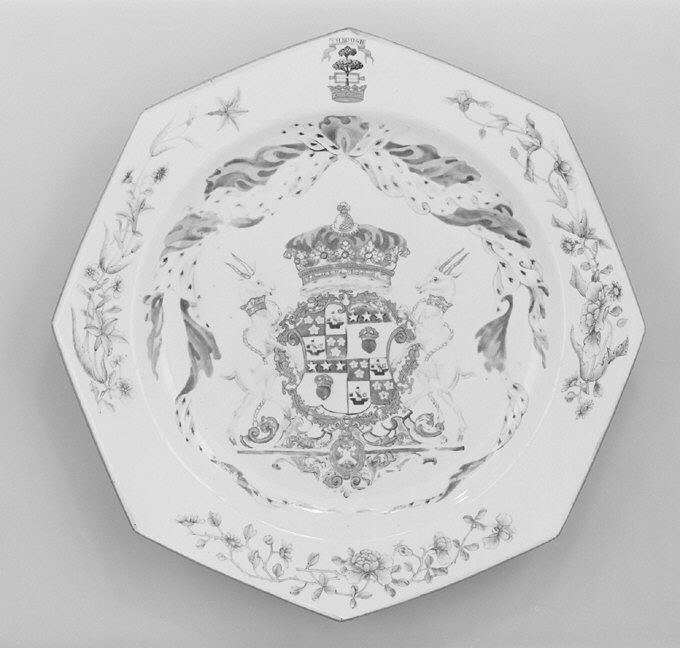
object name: dish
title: Dish (part of a service)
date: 1737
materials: hard paste porcelain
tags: flowers,coat of arms